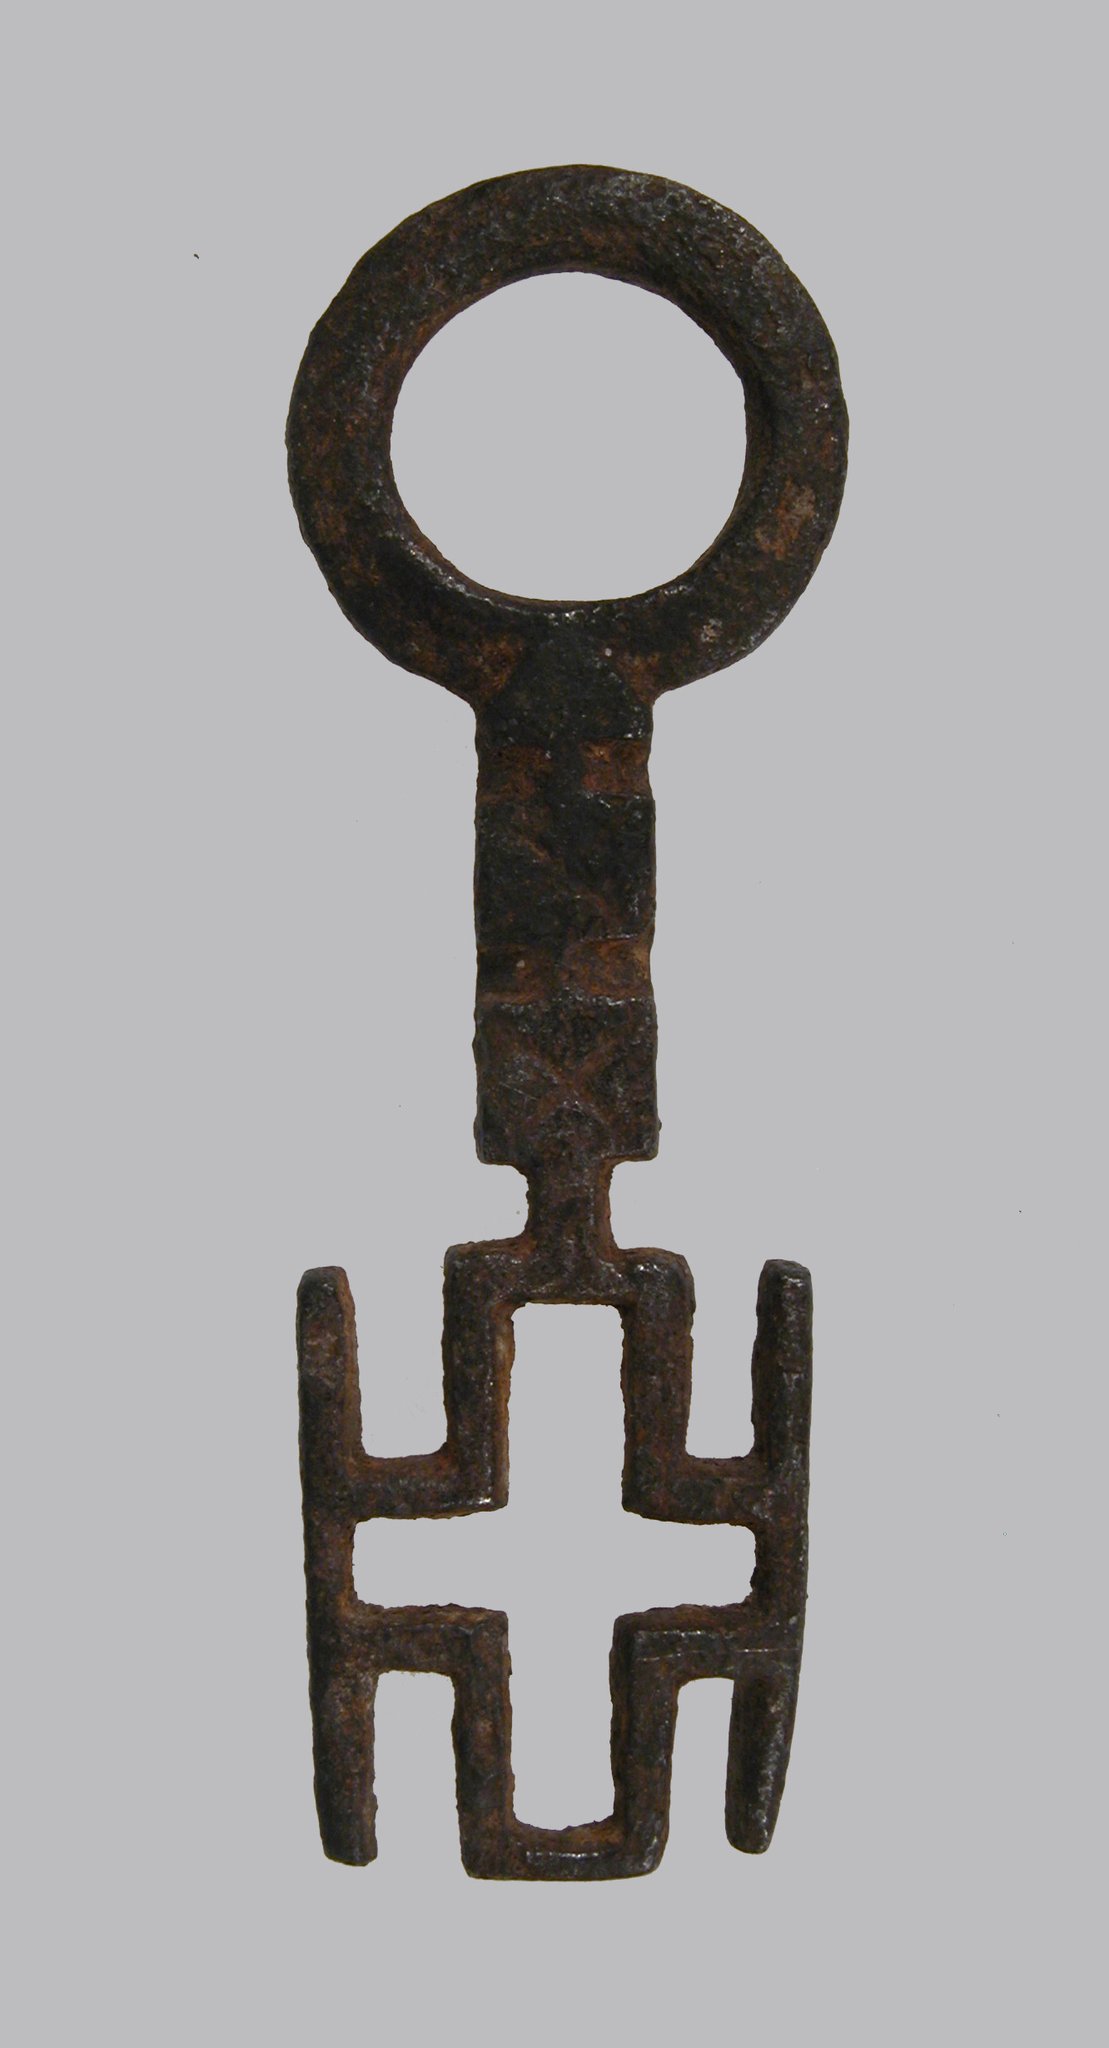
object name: key latch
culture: roman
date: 1-700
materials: iron